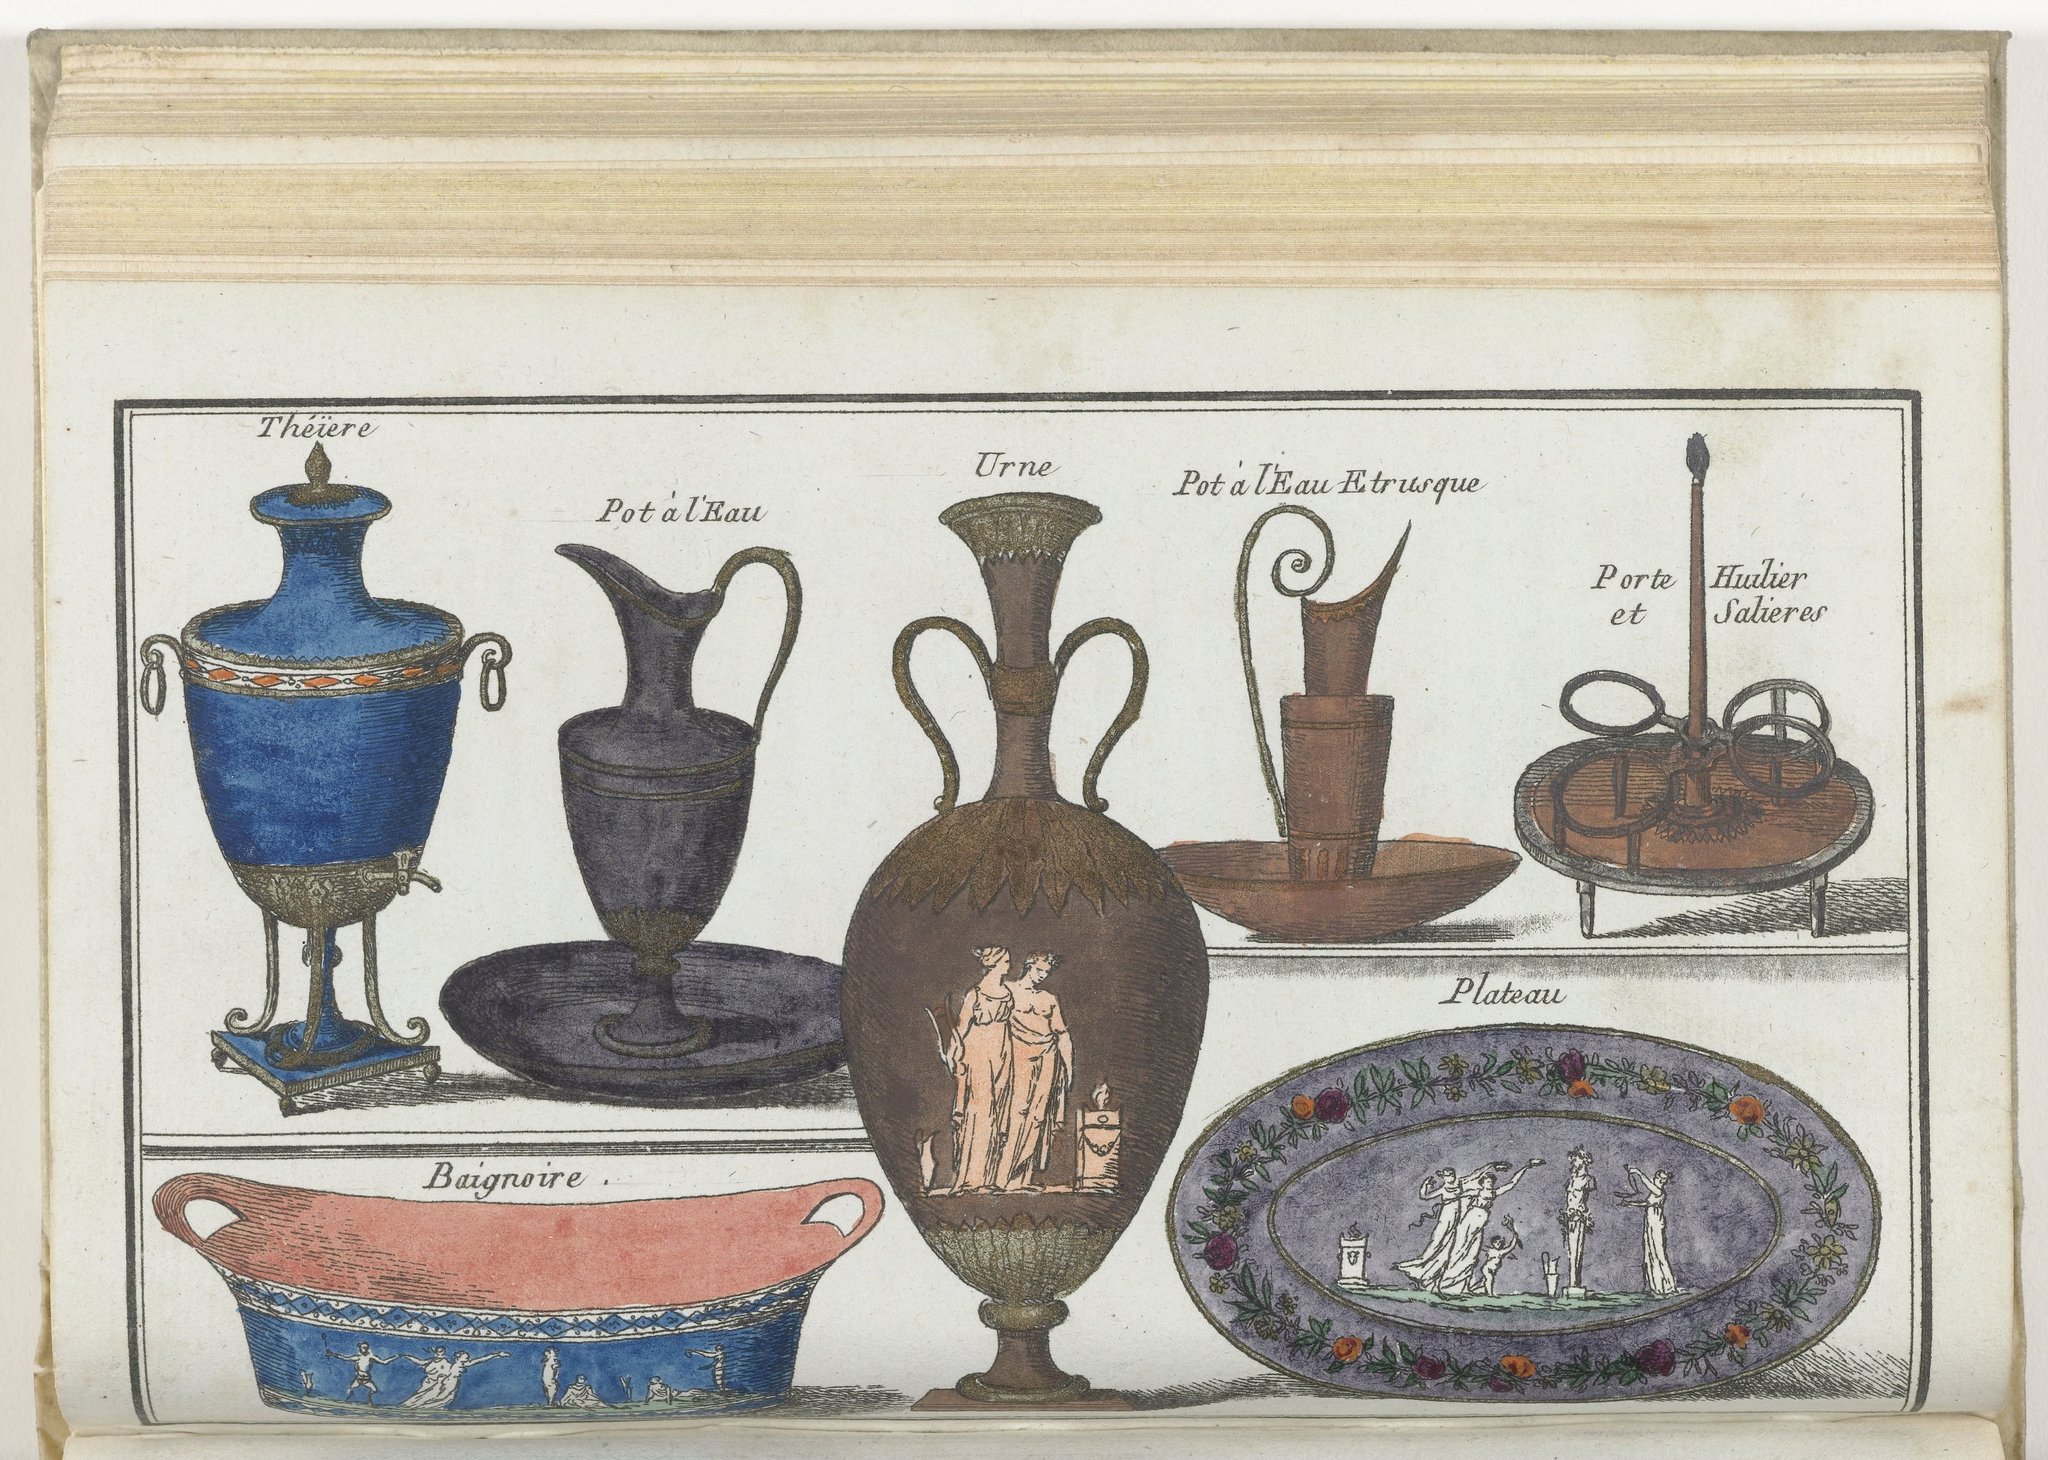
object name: print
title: Le Mois, Journal historique, littéraire et critique avec figures, Tome 2, An. 7 (1798-1799): Theiere, Pot a 'L'eau...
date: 1798-1799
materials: paper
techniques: etching, hand coloring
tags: table-ware, fashion plates, tea-pot; samovar, container of ceramics: jar, jug, pot, vase, dish, plate, saucer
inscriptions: inscription: ‘Théïere / Pot à l'eau / Urne / Pot à l'Eau Etrusque / Porte Huilier et Salieres’, inscription: ‘Baignoire / Plateau’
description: Voorbeelden van vaatwerk: Theiere, Pot a 'L'eau, Urne, Pot a l'Eau Etrusque.....Plateau. Prent uit het tijdschrift Le Mois : Journal historique, littéraire et critique avec figures, An 7 en 8 (1798-1800).